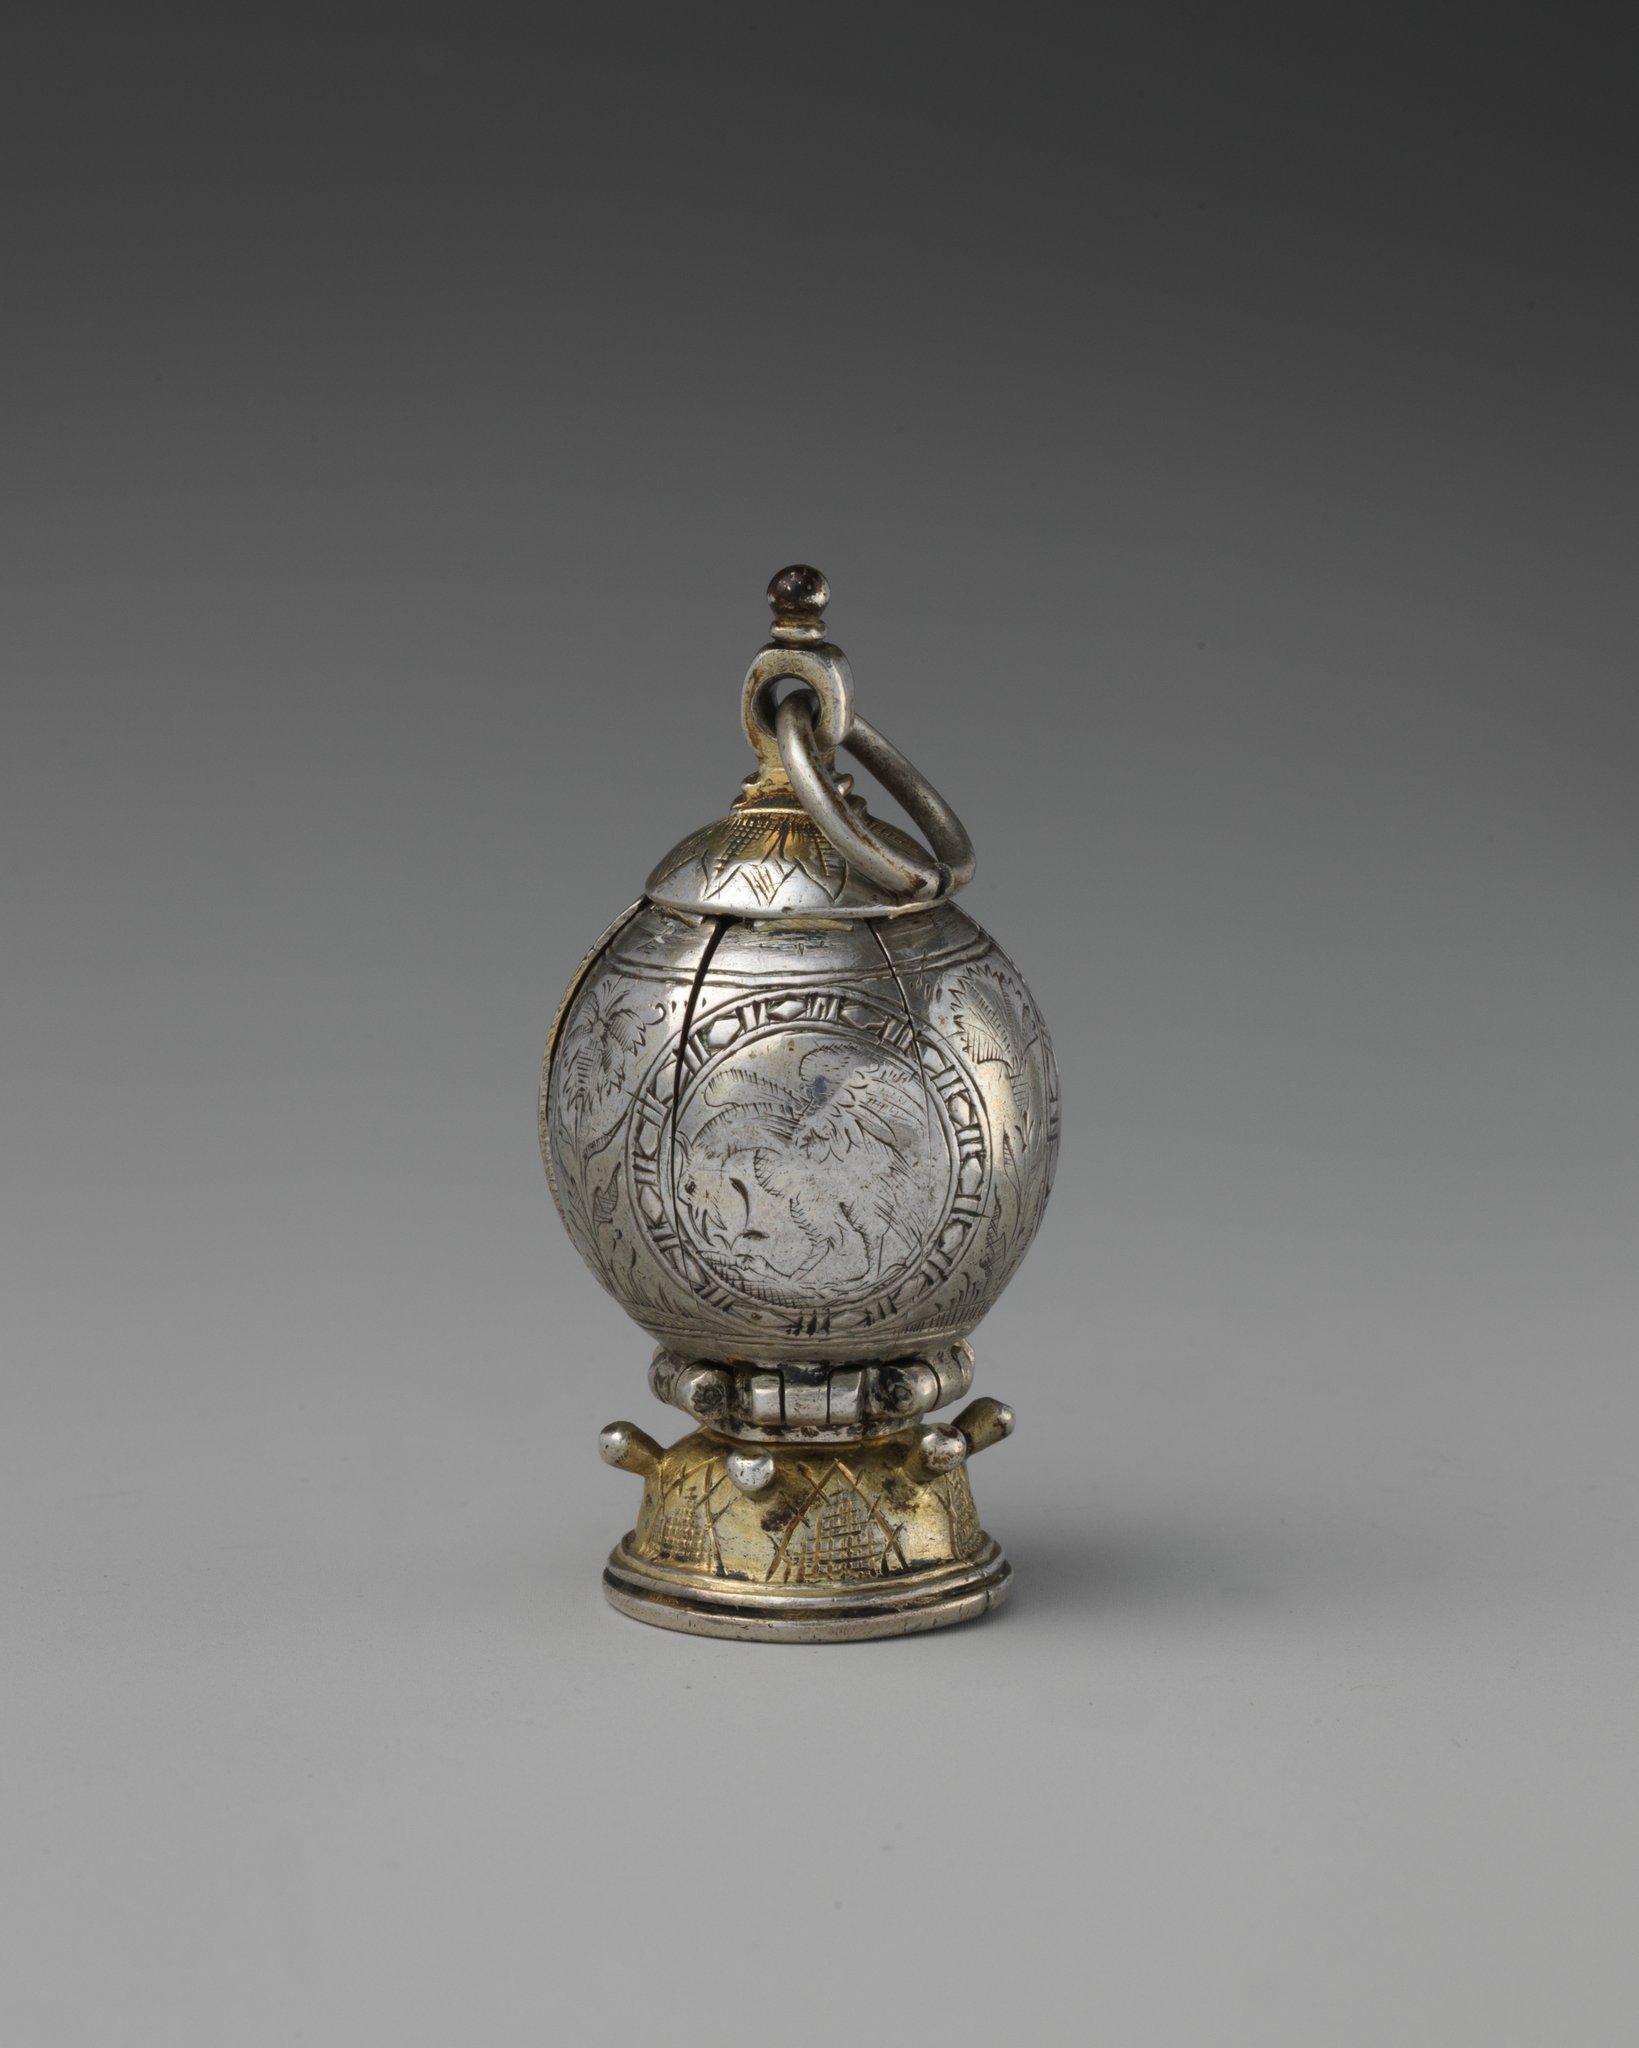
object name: pomander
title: Small pomander with six sections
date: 1601-1650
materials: gilt, silver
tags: birds